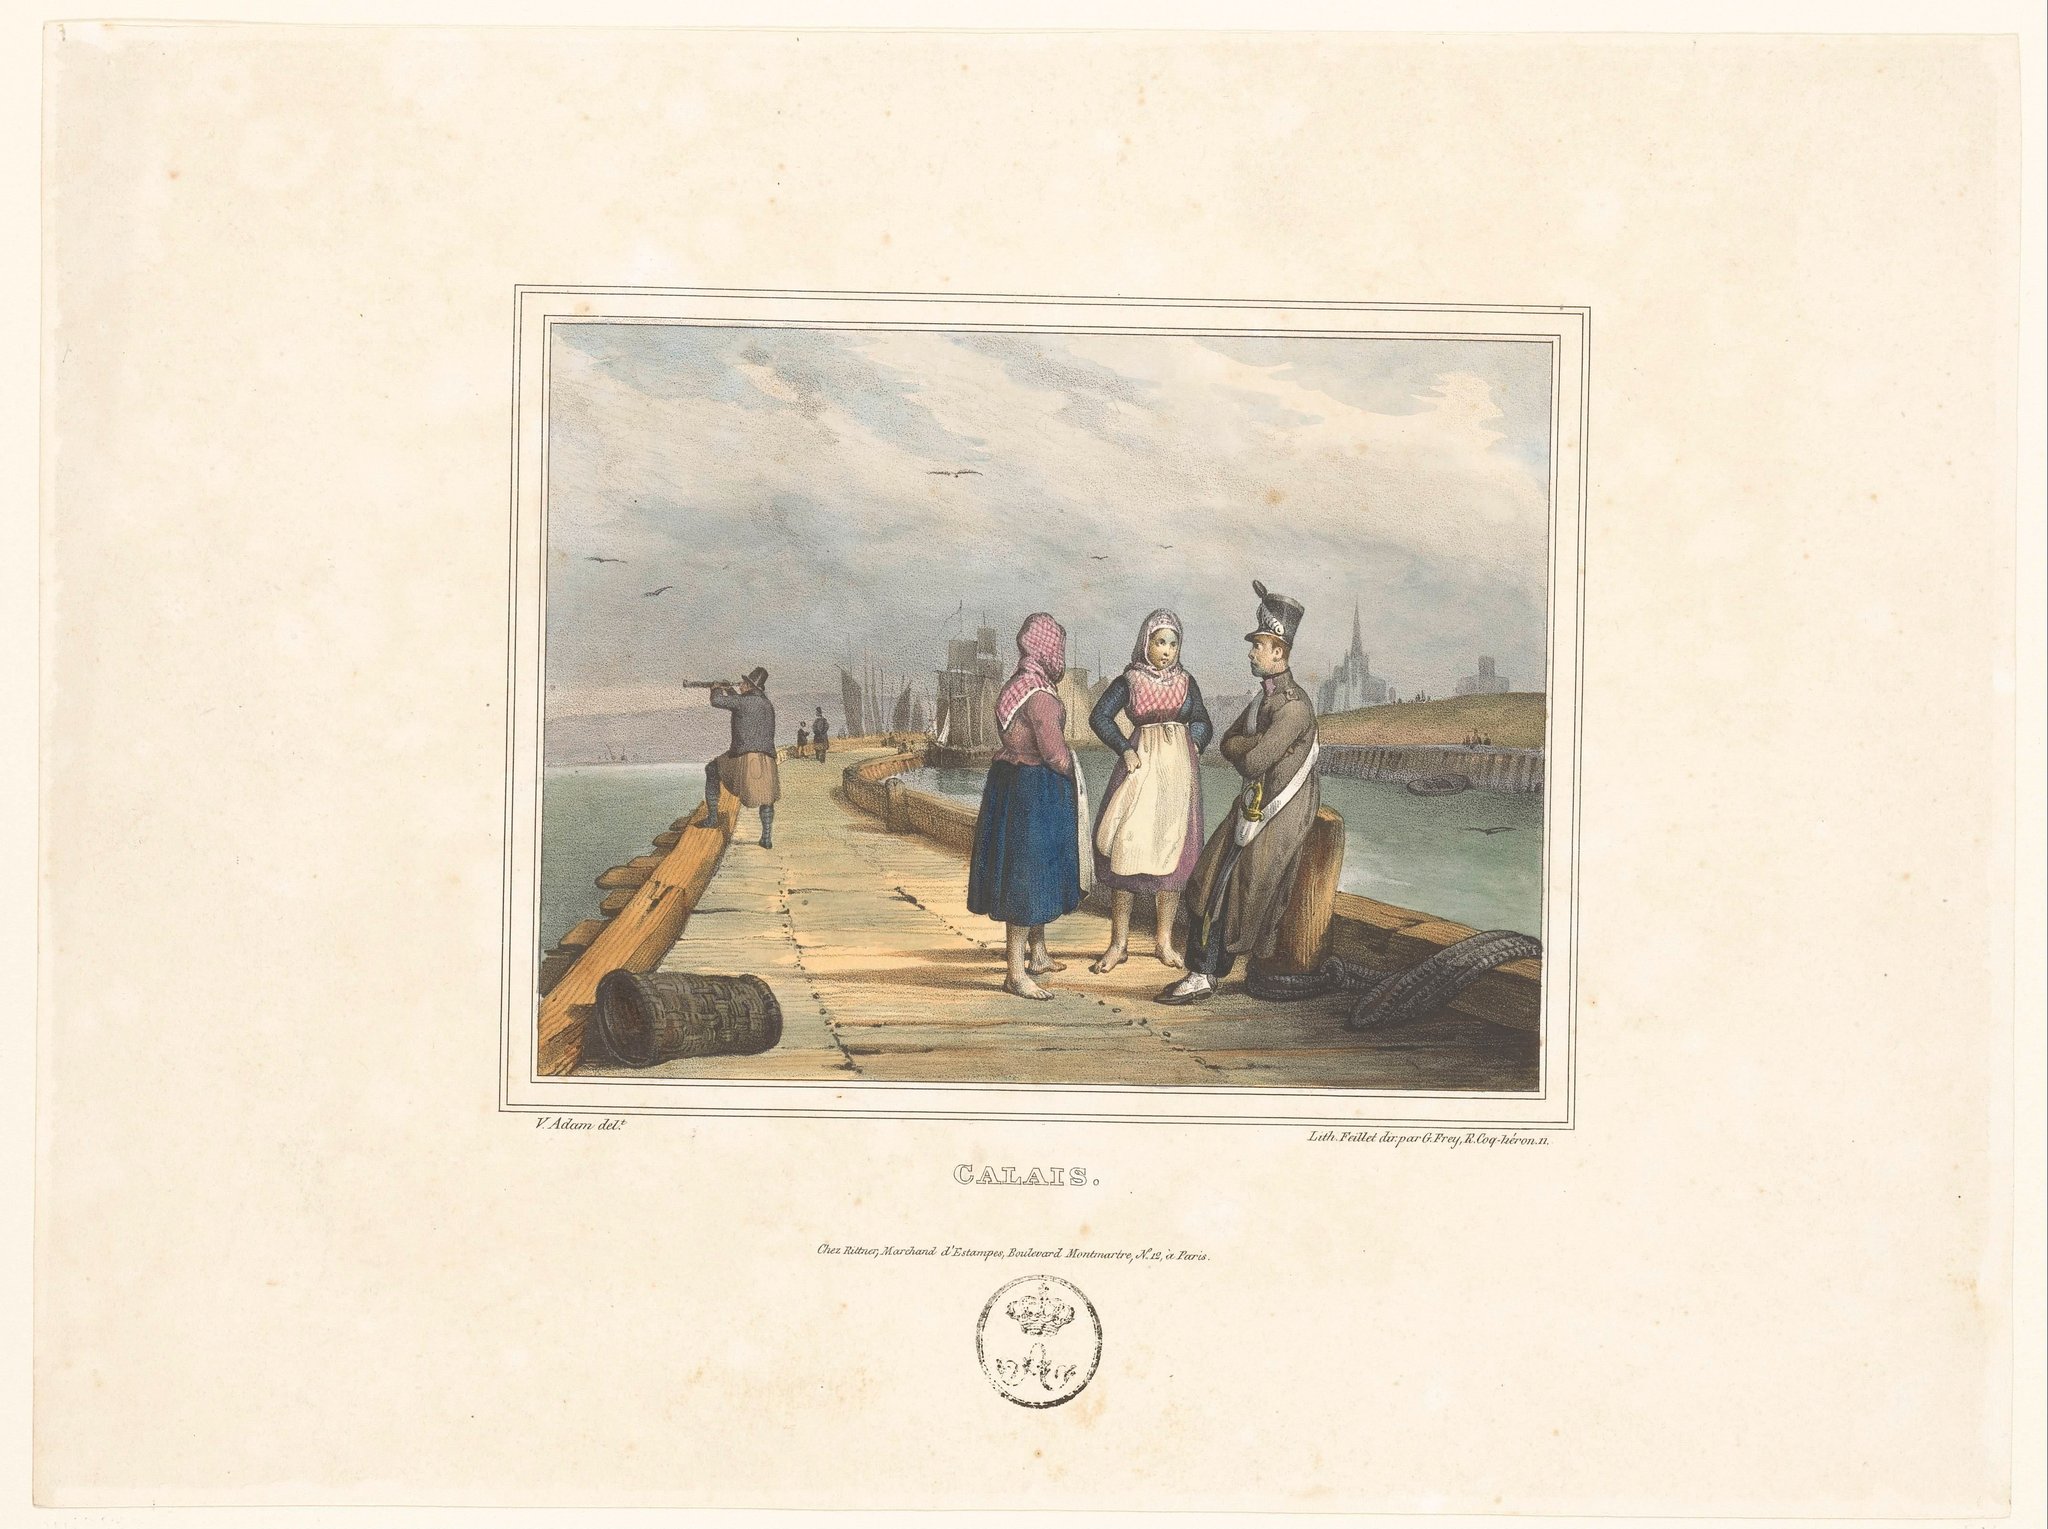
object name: print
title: Calais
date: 1827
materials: paper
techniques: hand coloring, lithograph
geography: paris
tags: folk costume, regional costume, pier, quay, wharf, coast (+ landscape with figures, staffage)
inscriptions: collector's mark: Lugt 2228, stamp: ‘A’